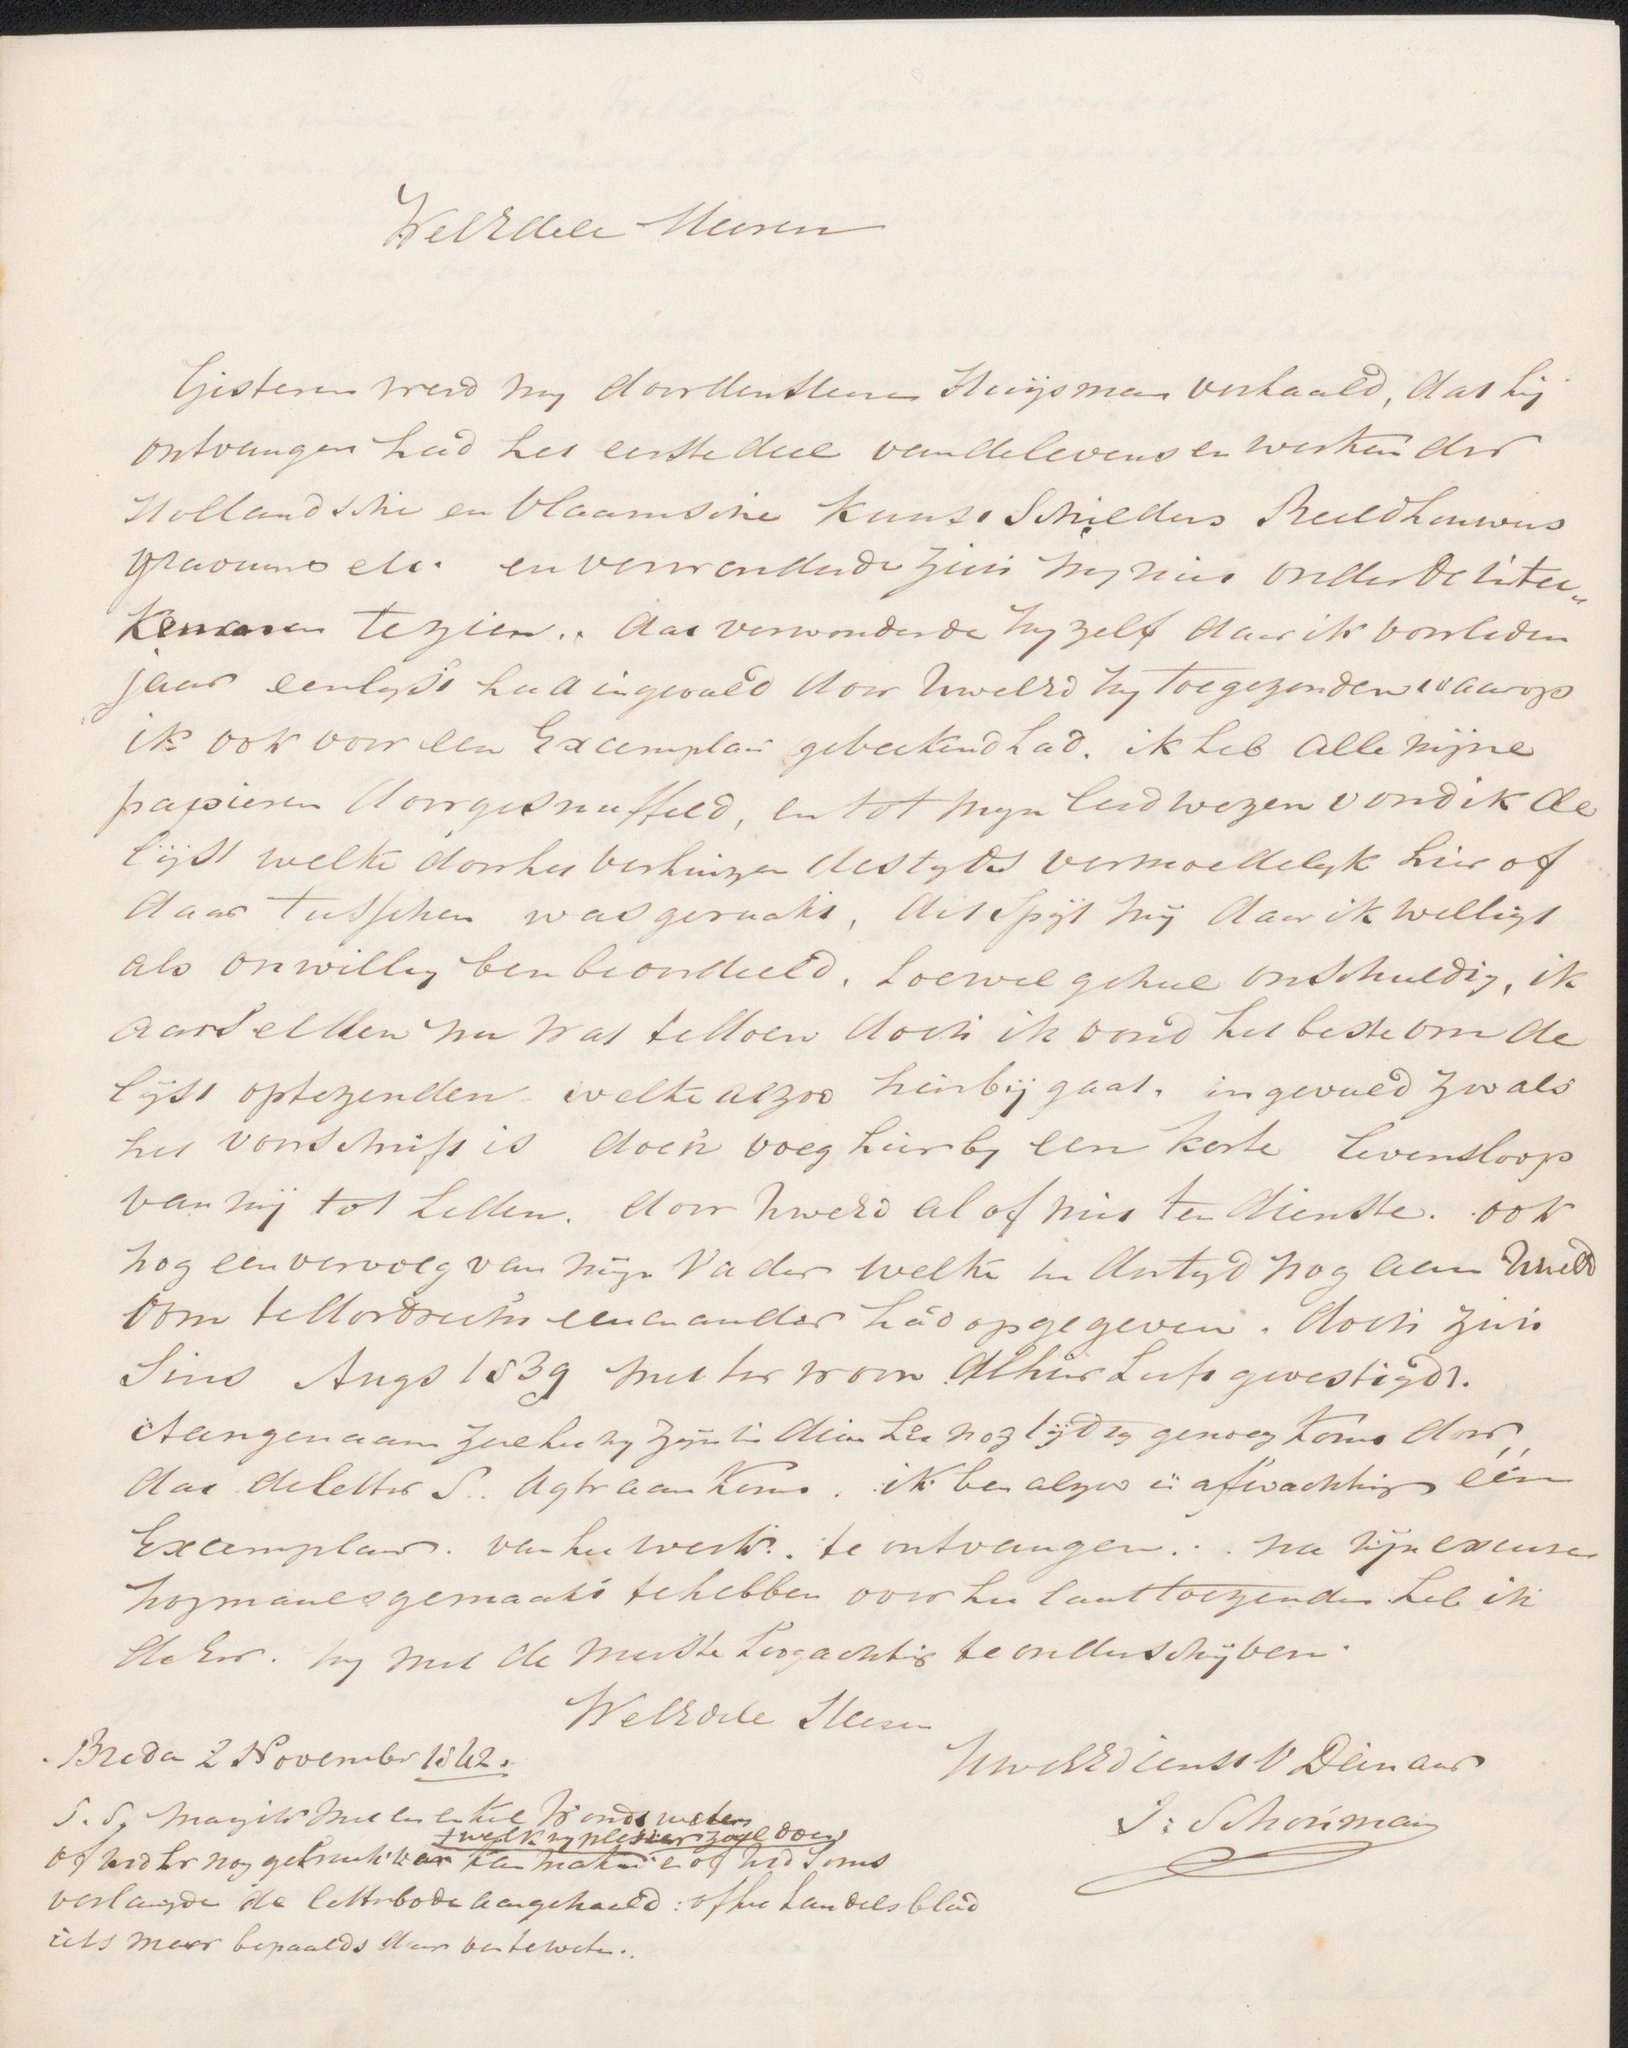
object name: letter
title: Brief aan anoniem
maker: izaak schouman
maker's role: draughtsman, painter, print maker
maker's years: 1801-1878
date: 1842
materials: ink, paper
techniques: pen, writing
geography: breda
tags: dordrecht, painter, draughtsman, martinus schouman, drawing, anonymous historical person portrayed, education, tuition of the artist (in general), painting (including book-illumination, miniature-painting), exhibition ~ art, delft